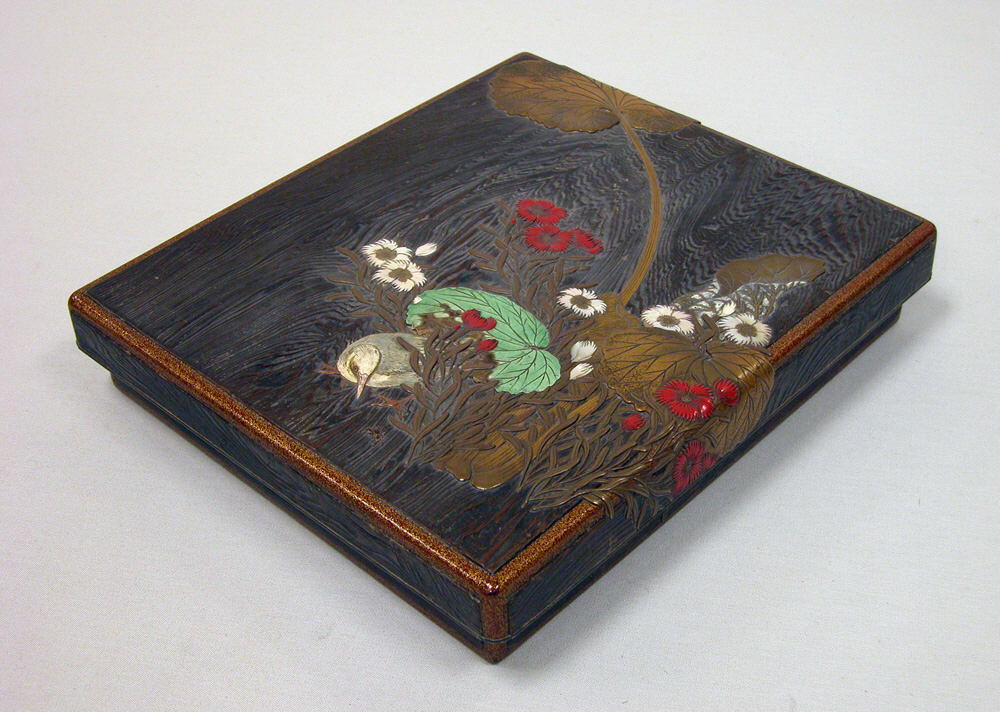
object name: writing box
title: Writing Box with Design of Wild Pink, Butterbar, and Bird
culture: japanese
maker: ogawa haritsu (ritsuō)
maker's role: artist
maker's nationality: japanese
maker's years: 1663-1747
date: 1867-1900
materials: gold, lacquer, pewter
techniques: inlay, maki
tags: birds,flowers